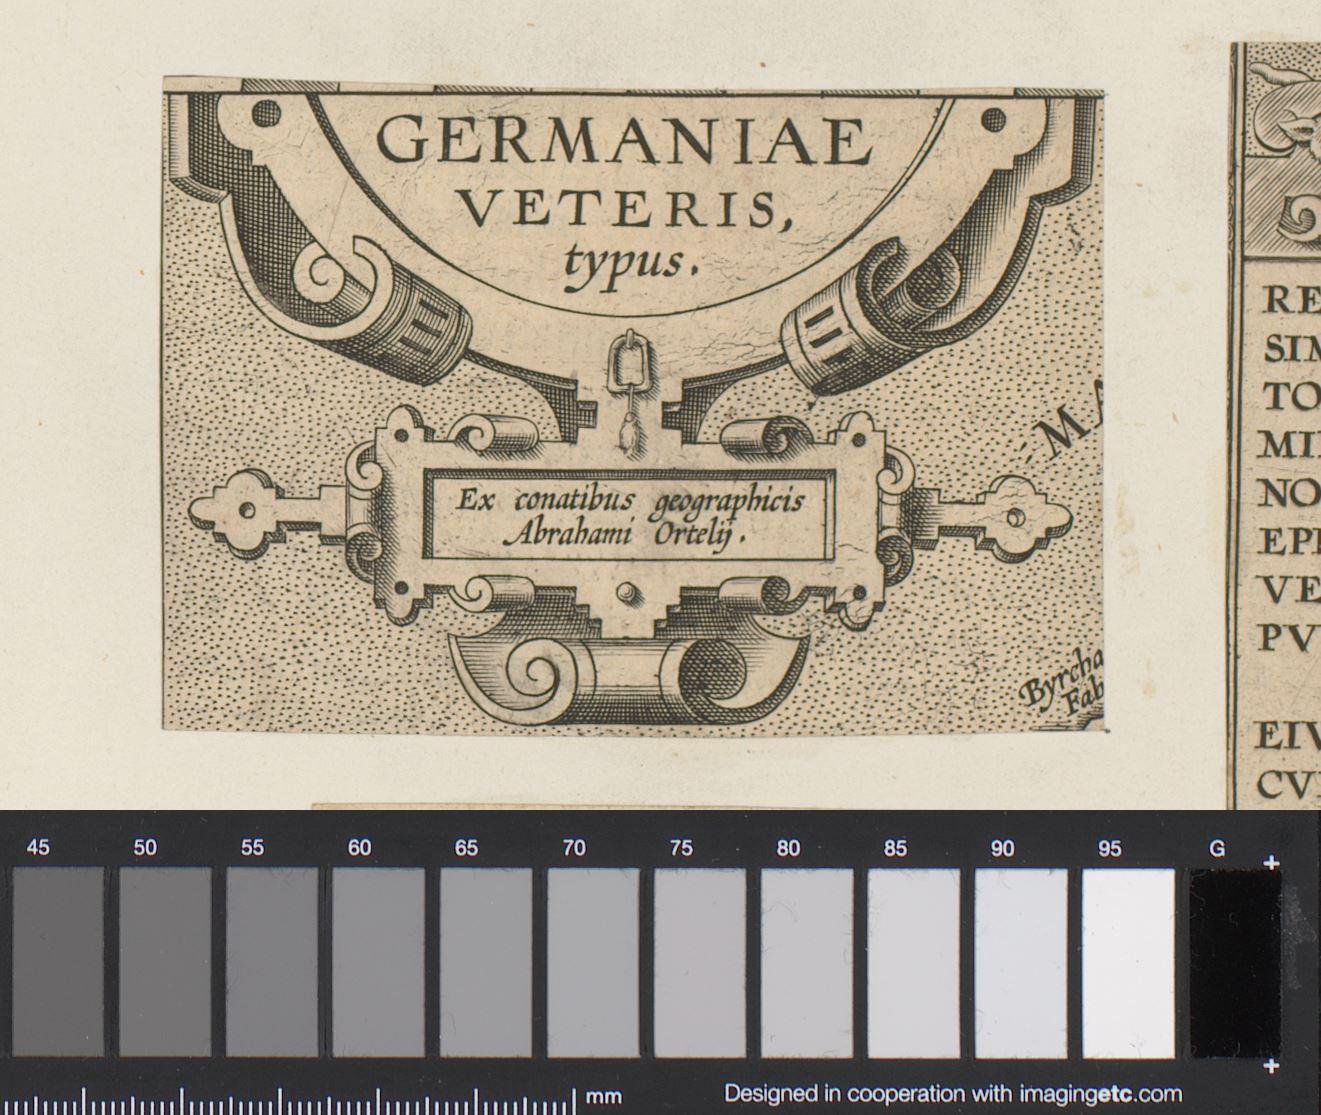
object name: ornament print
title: Germaniae Veteris typus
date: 1595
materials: paper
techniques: engraving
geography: antwerp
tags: scrollwork, strapwork ~ ornament, ornament ~ cartouche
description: De cartouche is gekopieerd naar een prent van een anonieme graveur naar het ontwerp van Hans Vredeman de Vries, onderdeel van een serie van rolwerkcartouches met grotesken uit circa 1555-1560.